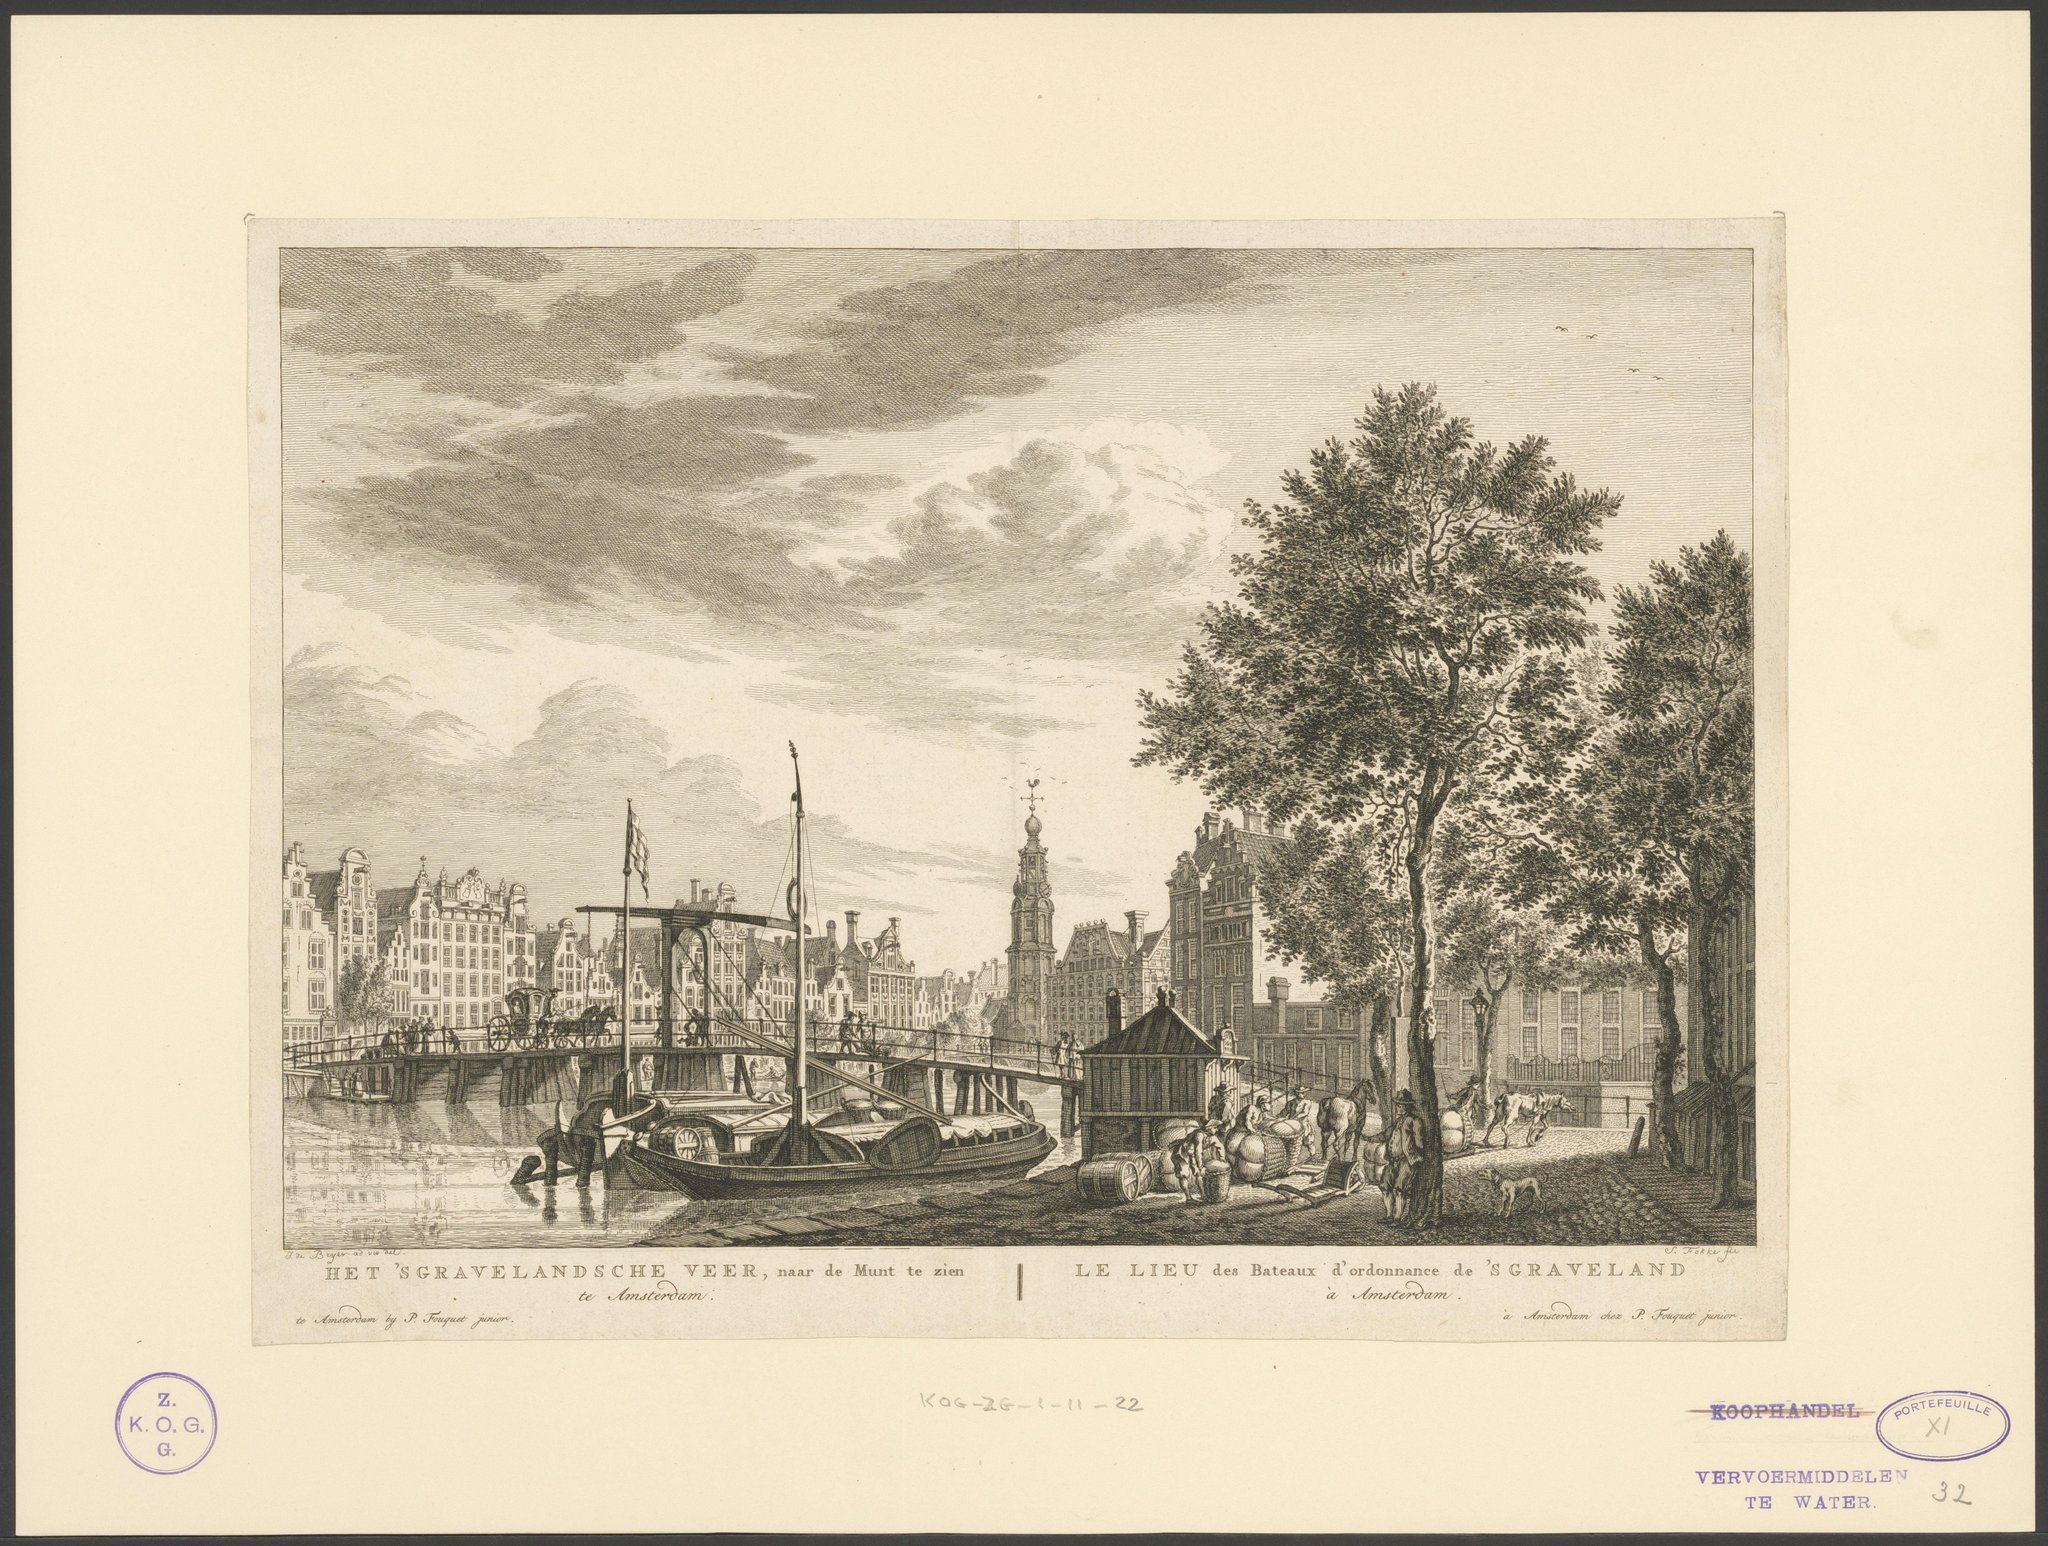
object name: print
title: Het 's Gravelandsche veer, naar de Munt te zien te Amsterdam / Le lieu des Bateaux d'ordonnance de 's Graveland à Amsterdam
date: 1760-1783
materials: paper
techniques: lithograph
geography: amsterdam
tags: bridge in city across river, canal, etc. (+ city(-scape) with figures, staffage), tower, clock tower ~ monumental adornment, ferry, canals, waters (in city) (+ city(-scape) with figures, staffage), street (+ city(-scape) with figures, staffage)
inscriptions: stamp, stamp, stamp, collector's mark: Lugt 1641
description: Deze prent is ook gebruikt in de zogenaamde Atlas van Fouquet.* Pierre Fouquet gaf vanaf 1760 stadsgezichten van Amsterdam - naar tekeningen van verschillende kunstenaars, gemaakt door verschillende prentmakers - uit. Deze prenten werden aanvankelijk los of in series verkocht. Zoals toen gebruikelijk kon de koper de prenten zelf laten inbinden. Hiertoe gaf Fouquet tussen 1778 en 1783 een titelblad, plattegrond en inhoudsopgave van de tot dusver 100 uitgegeven prenten uit (1). Gezien de inhoud afhankelijk was van wat de koper had verzameld verschilt de inhoud van de verschillende bewaarde Fouquetatlassen onder deze titel sterk. Ook zijn er exemplaren bekend waar tevens andere prenten aan zijn toegevoegd. Omdat er behoefte bleek aan uitleg bij de platen werd in 1783 een nieuwe versie van de atlas uitgegeven, aangevuld met tekst en twee prenten. De aangegeven volgorde veranderde maar de platen van de al eerder uitgegeven prenten bleven ongewijzigd. Deze uitgave werd in opdracht van Fouquet gedrukt bij Daniël Jean Changuion en Petrus den Hengst (2). Een tiental platen werd bijgewerkt en verscheen, met nieuw impressum, in het vervolg van Wagenaars geschiedenis van Amsterdam, uitgeven door Petrus Conradi en Folkert van der Plaats (3). Een aantal jaar na het overlijden van Fouquet kwam Evert Maaskamp met een nieuwe uitgave van de atlas, met verbeterde tekst en toevoeging van twee prenten. Op alle platen verwijderde hij het oude en liet hij zijn eigen impressum zetten (4). De huidige staat van de prent komt voor in exemplaren van de onder (1) en (2) genoemde werken. * Onder de Atlas van Fouquet of Fouquetatlas verstaan we de hieronder vermelde publicaties (1), (2) en (4). (1). Afbeeldingen van de wyd-vermaarde koopstad Amsterdam benevens des zelvs voornaamste gebouwen en gezigten alle naar het leeven getekend / Receuil des edifices les plus considerables et des plus belles vues, de la fameuse ville d'Amsterdam, dessinées d'après nature. Amsterdam: Pierre Fouquet, 1778-1783. (2). Nieuwe atlas, van de voornaamste gebouwen en gezigten der stad Amsterdam, met derzelver beknopte beschryvingen. 2 dln. Amsterdam: Daniël Jean Changuion en Petrus den Hengst [in opdracht van Pierre Fouquet], 1783. (3). Stijl, Simon. Amsterdam, in zyne geschiedenissen, voorregten, koophandel, gebouwen, kerkenstaat, schoolen, schutterye, gilden en regeeringe, beschreeven. Om te dienen ten vervolge op het werk van Jan Wagenaar (…). 10 dln. Amsterdam en Harlingen: Petrus Conradi en Folkert van der Plaats, 1788-1801. (4). Nieuwe atlas, van de voornaamste gebouwen en gezigten der stad Amsterdam. Met derzelver beknopte beschryvingen. Amsterdam: Evert Maaskamp, 1805. * Het aantal vermelde staten is gebaseerd op het aantal gevonden staten. Mogelijk zijn er meer staten van deze prent. Zie RP-P-1905-396 voor eerste of tweede bekende staat. Zie RP-P-AO-27-30A en RP-P-1905-397 voor vierde bekende staat.